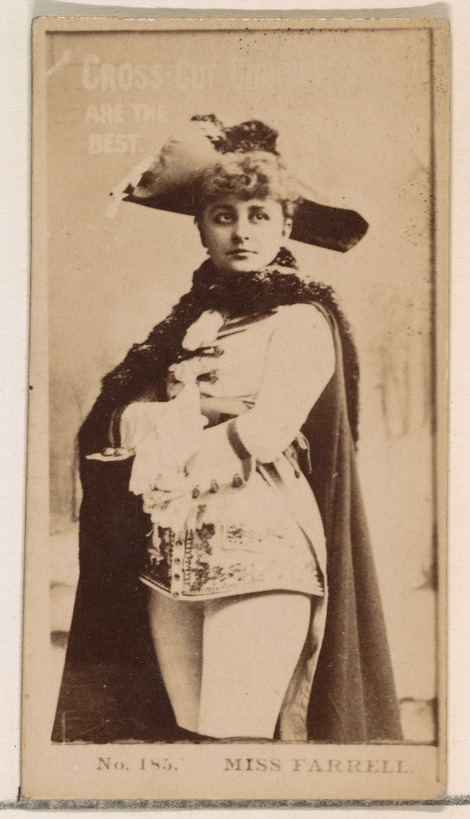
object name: print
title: Card Number 185, Miss Farrell, from the Actors and Actresses series (N145-2) issued by Duke Sons & Co. to promote Cross Cut Cigarettes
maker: w. duke, sons & co.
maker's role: publisher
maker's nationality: american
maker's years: 1870-1920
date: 1880-1889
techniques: albumen silver print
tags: portraits,women,actresses